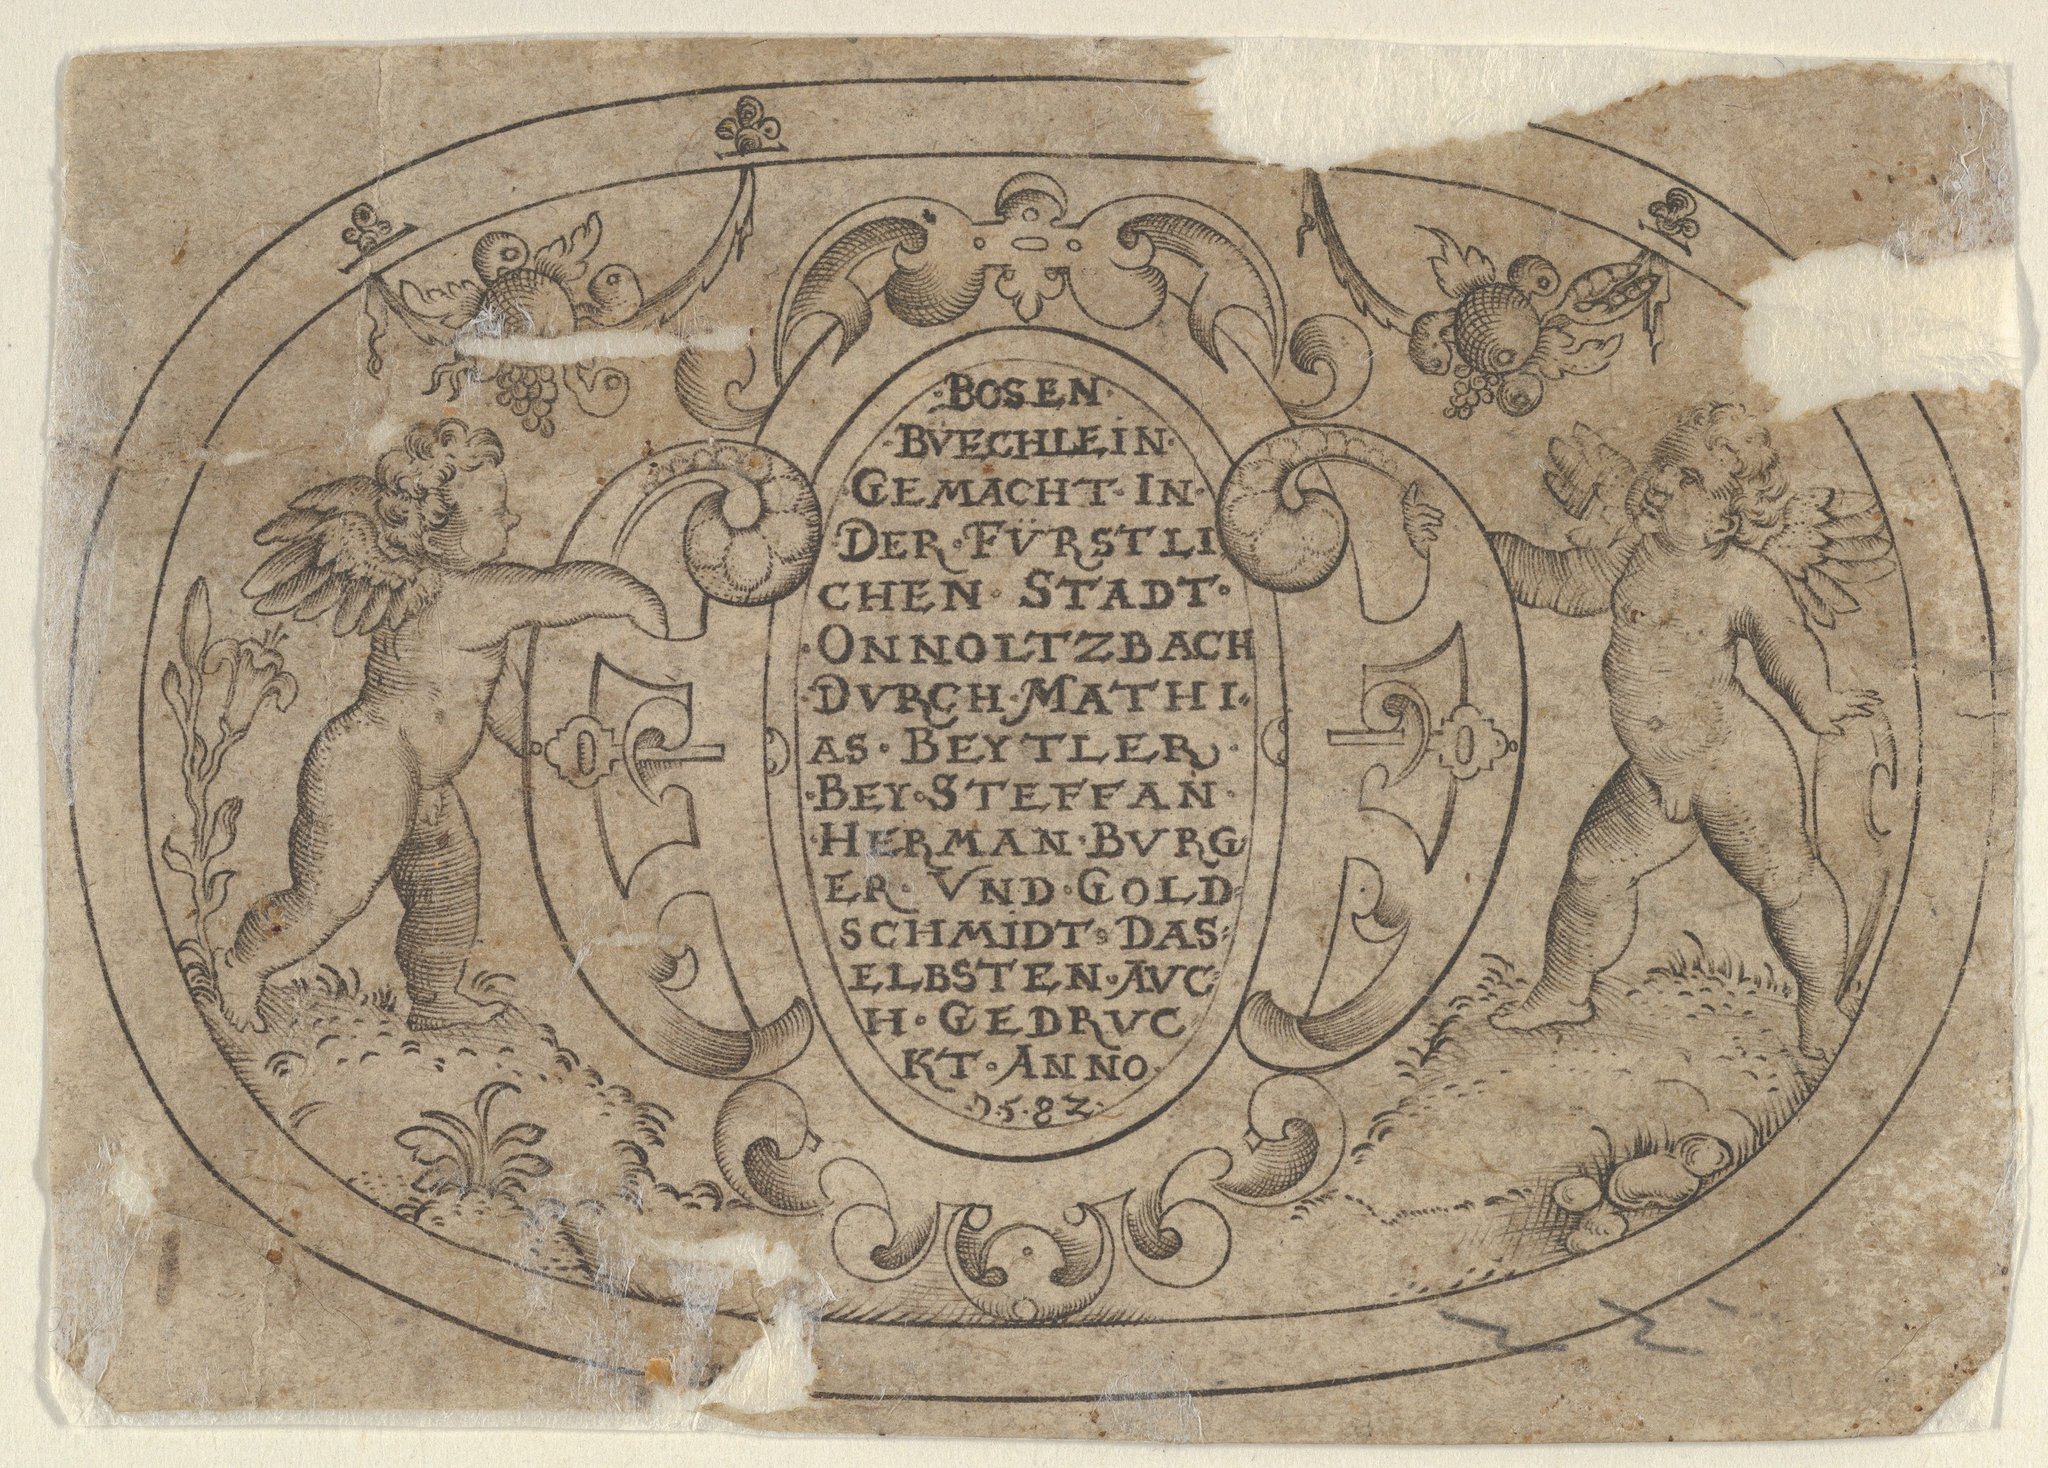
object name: print ornament architecture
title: Title-Plate, from Das Bossenbüchlein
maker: mathais beitler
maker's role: artist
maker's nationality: german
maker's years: 1582-1616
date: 1582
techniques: engraving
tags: putti